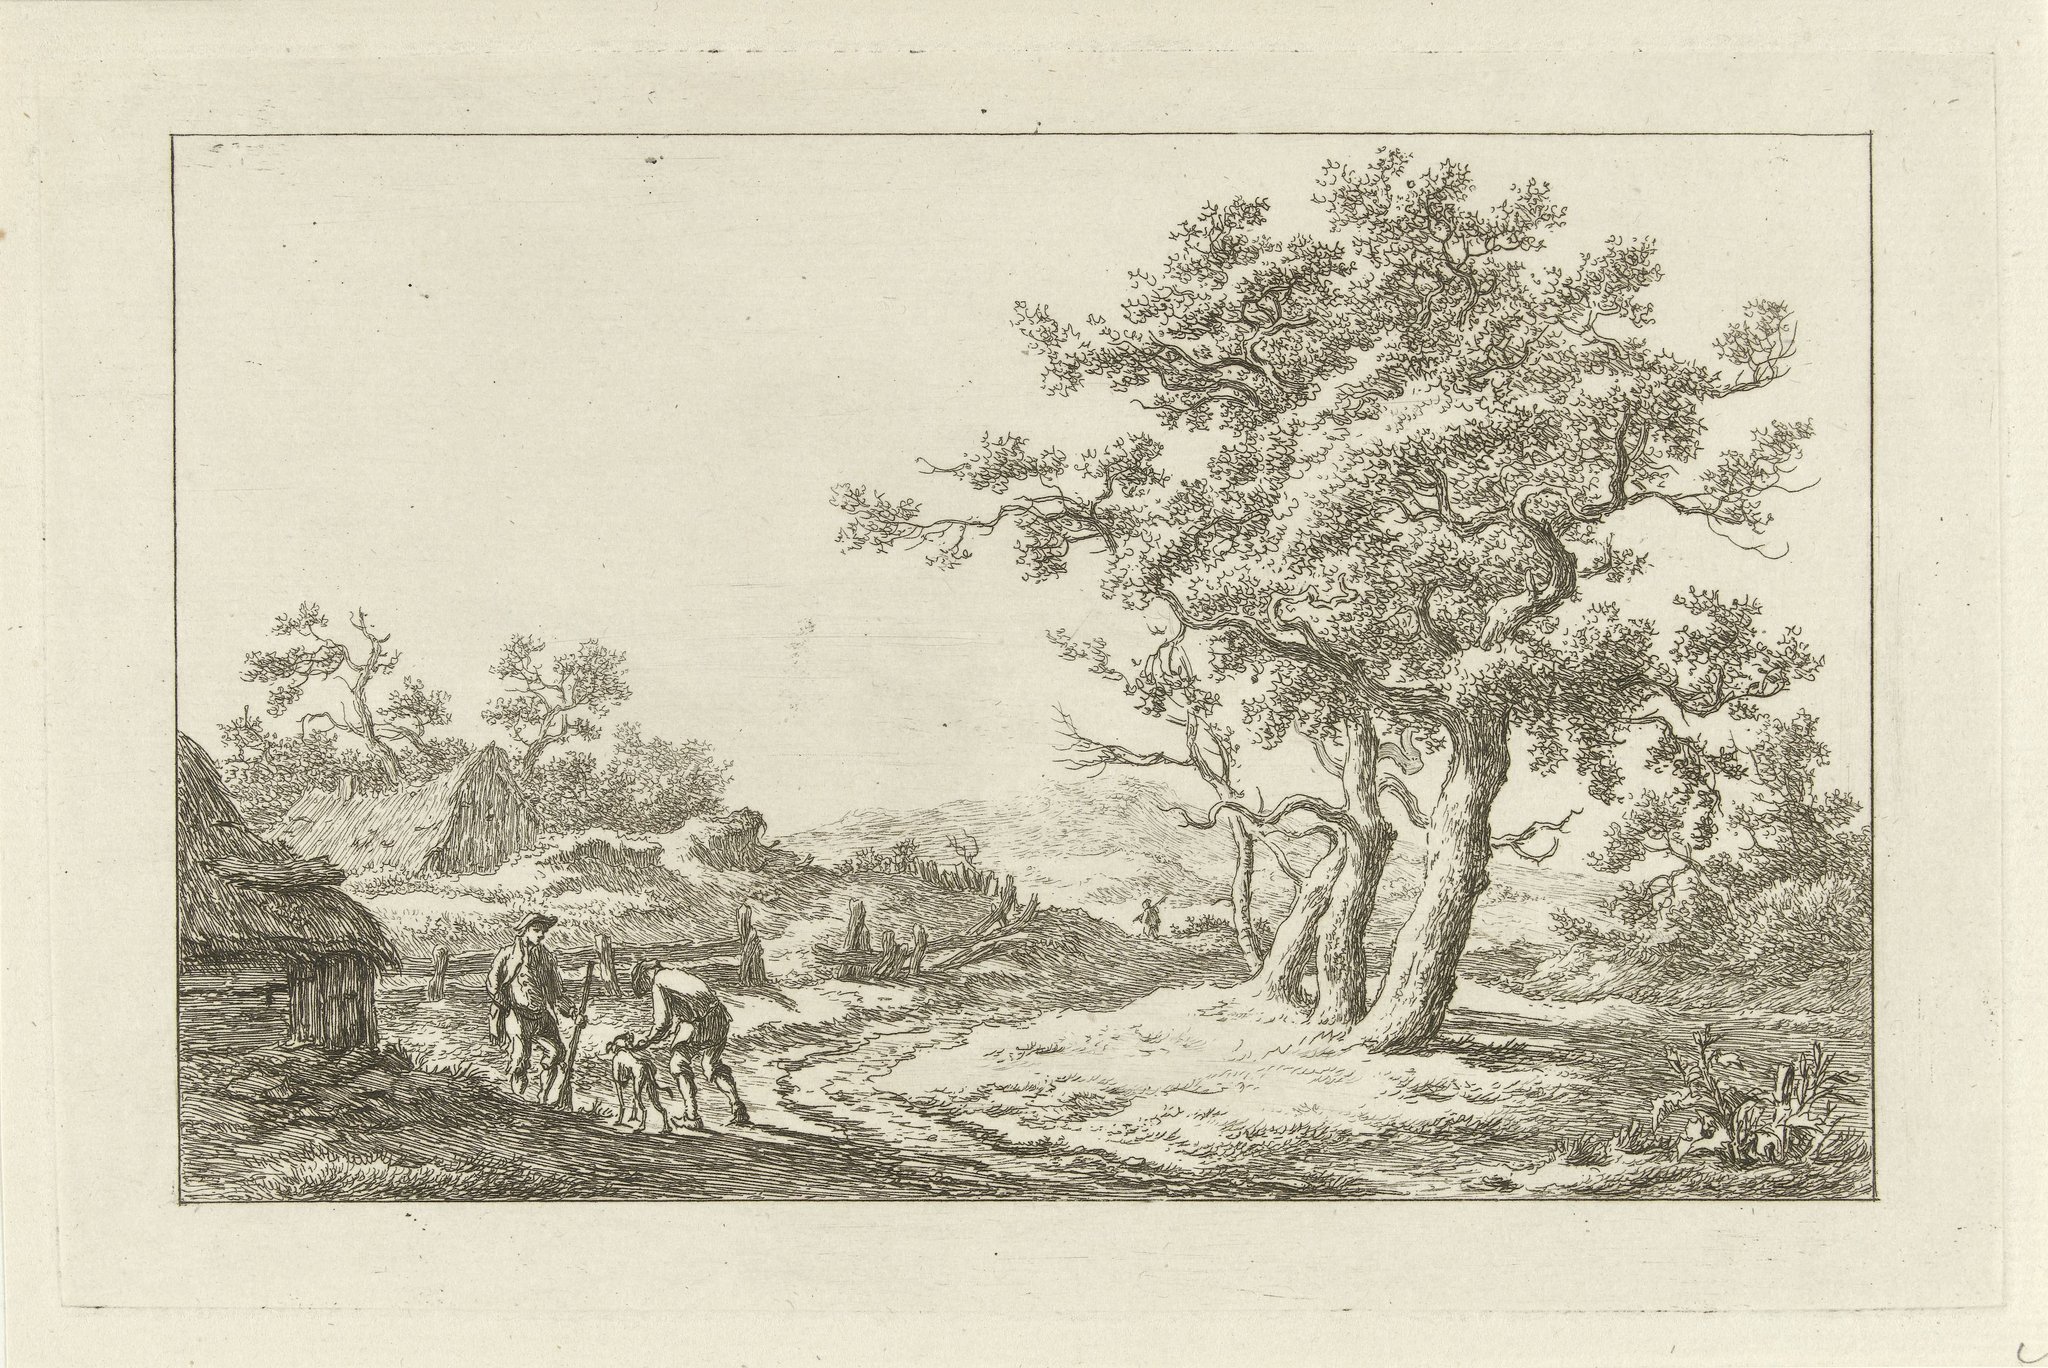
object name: print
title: Jagers met een hond op een pad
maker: carel lodewijk hansen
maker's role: draughtsman, painter, print maker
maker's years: 1765-1840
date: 1780-1840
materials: paper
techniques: etching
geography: netherlands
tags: hunter, landscapes (+ landscape with figures, staffage), dog, haarlem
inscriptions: collector's mark: Lugt 2228